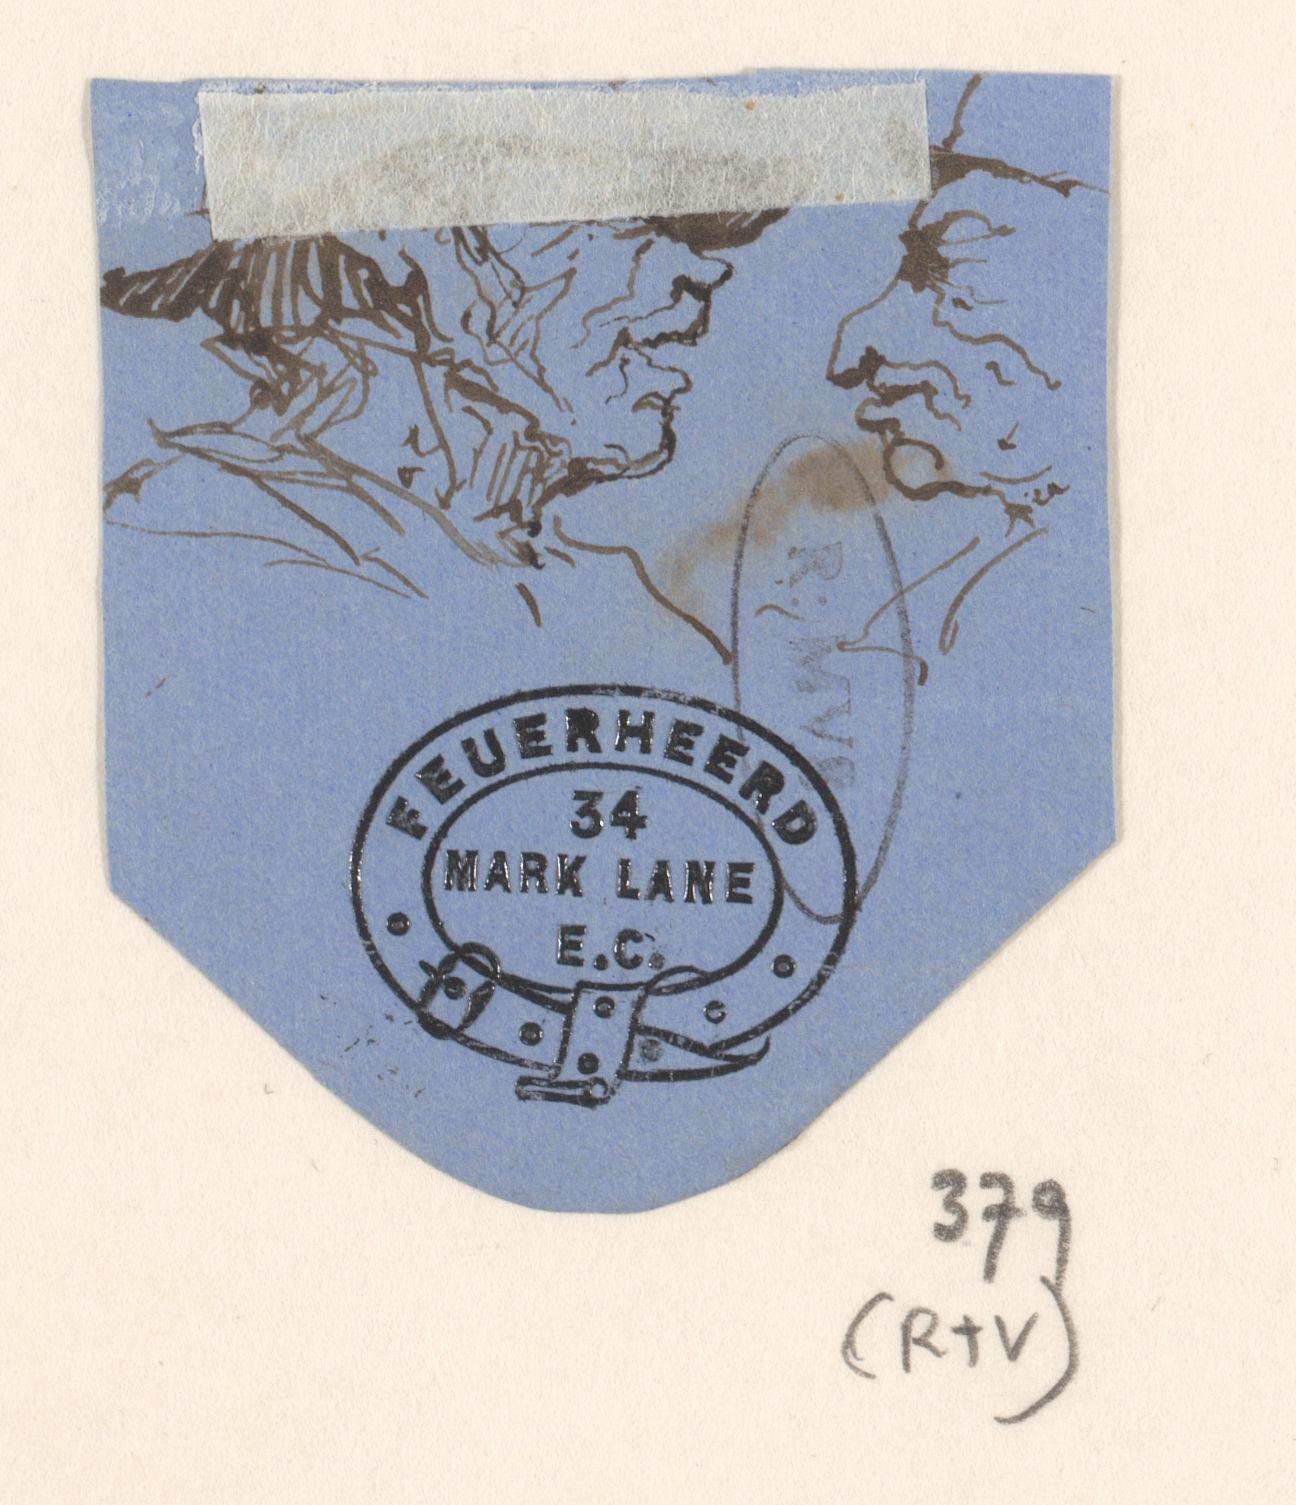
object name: drawing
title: Twee koppen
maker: johannes tavenraat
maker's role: draughtsman, painter, print maker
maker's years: 1809-1881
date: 1840-1880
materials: ink, paper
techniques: pen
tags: caricatures (human types)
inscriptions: collector's mark: Lugt 2228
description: Twee koppen. Getekend op een fragment van een envelop.